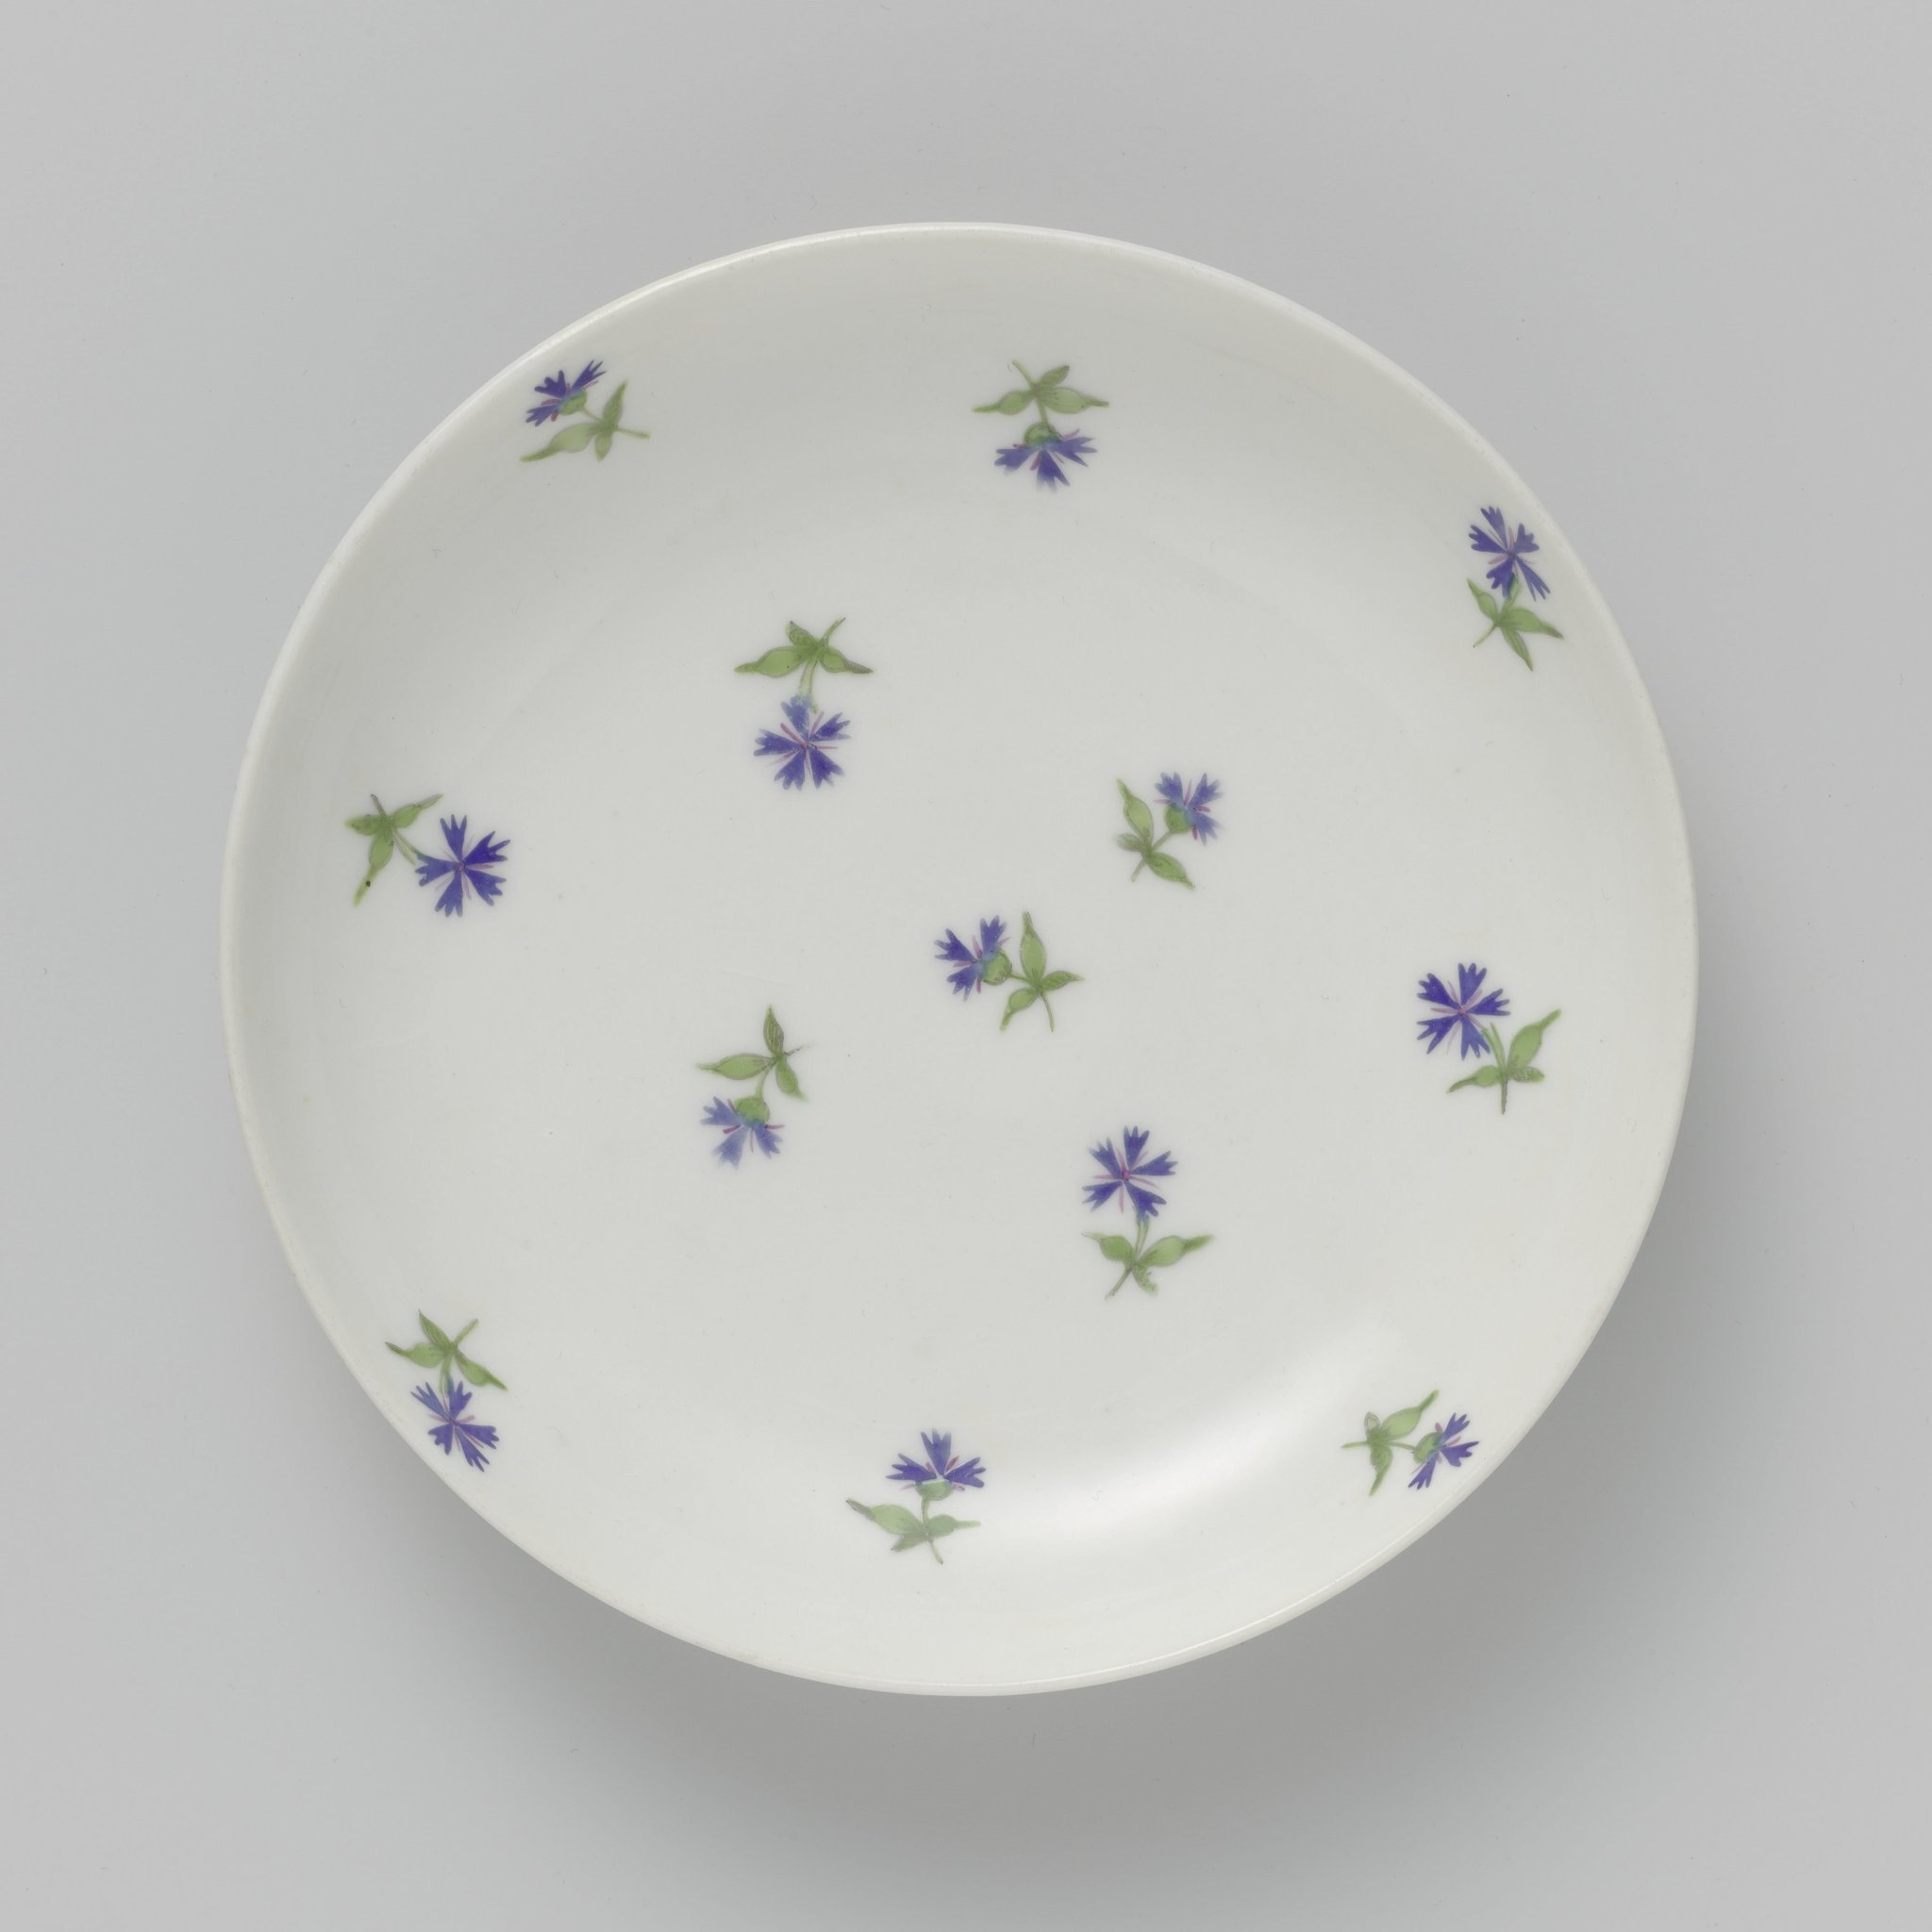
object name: platter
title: Schotel, beschilderd met korenbloemen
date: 1784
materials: porcelain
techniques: painted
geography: loosdrecht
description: Schotel, versierd met korenbloemen. Gemerkt Amstel in blauw onder het glazuur en ingegrift L1.